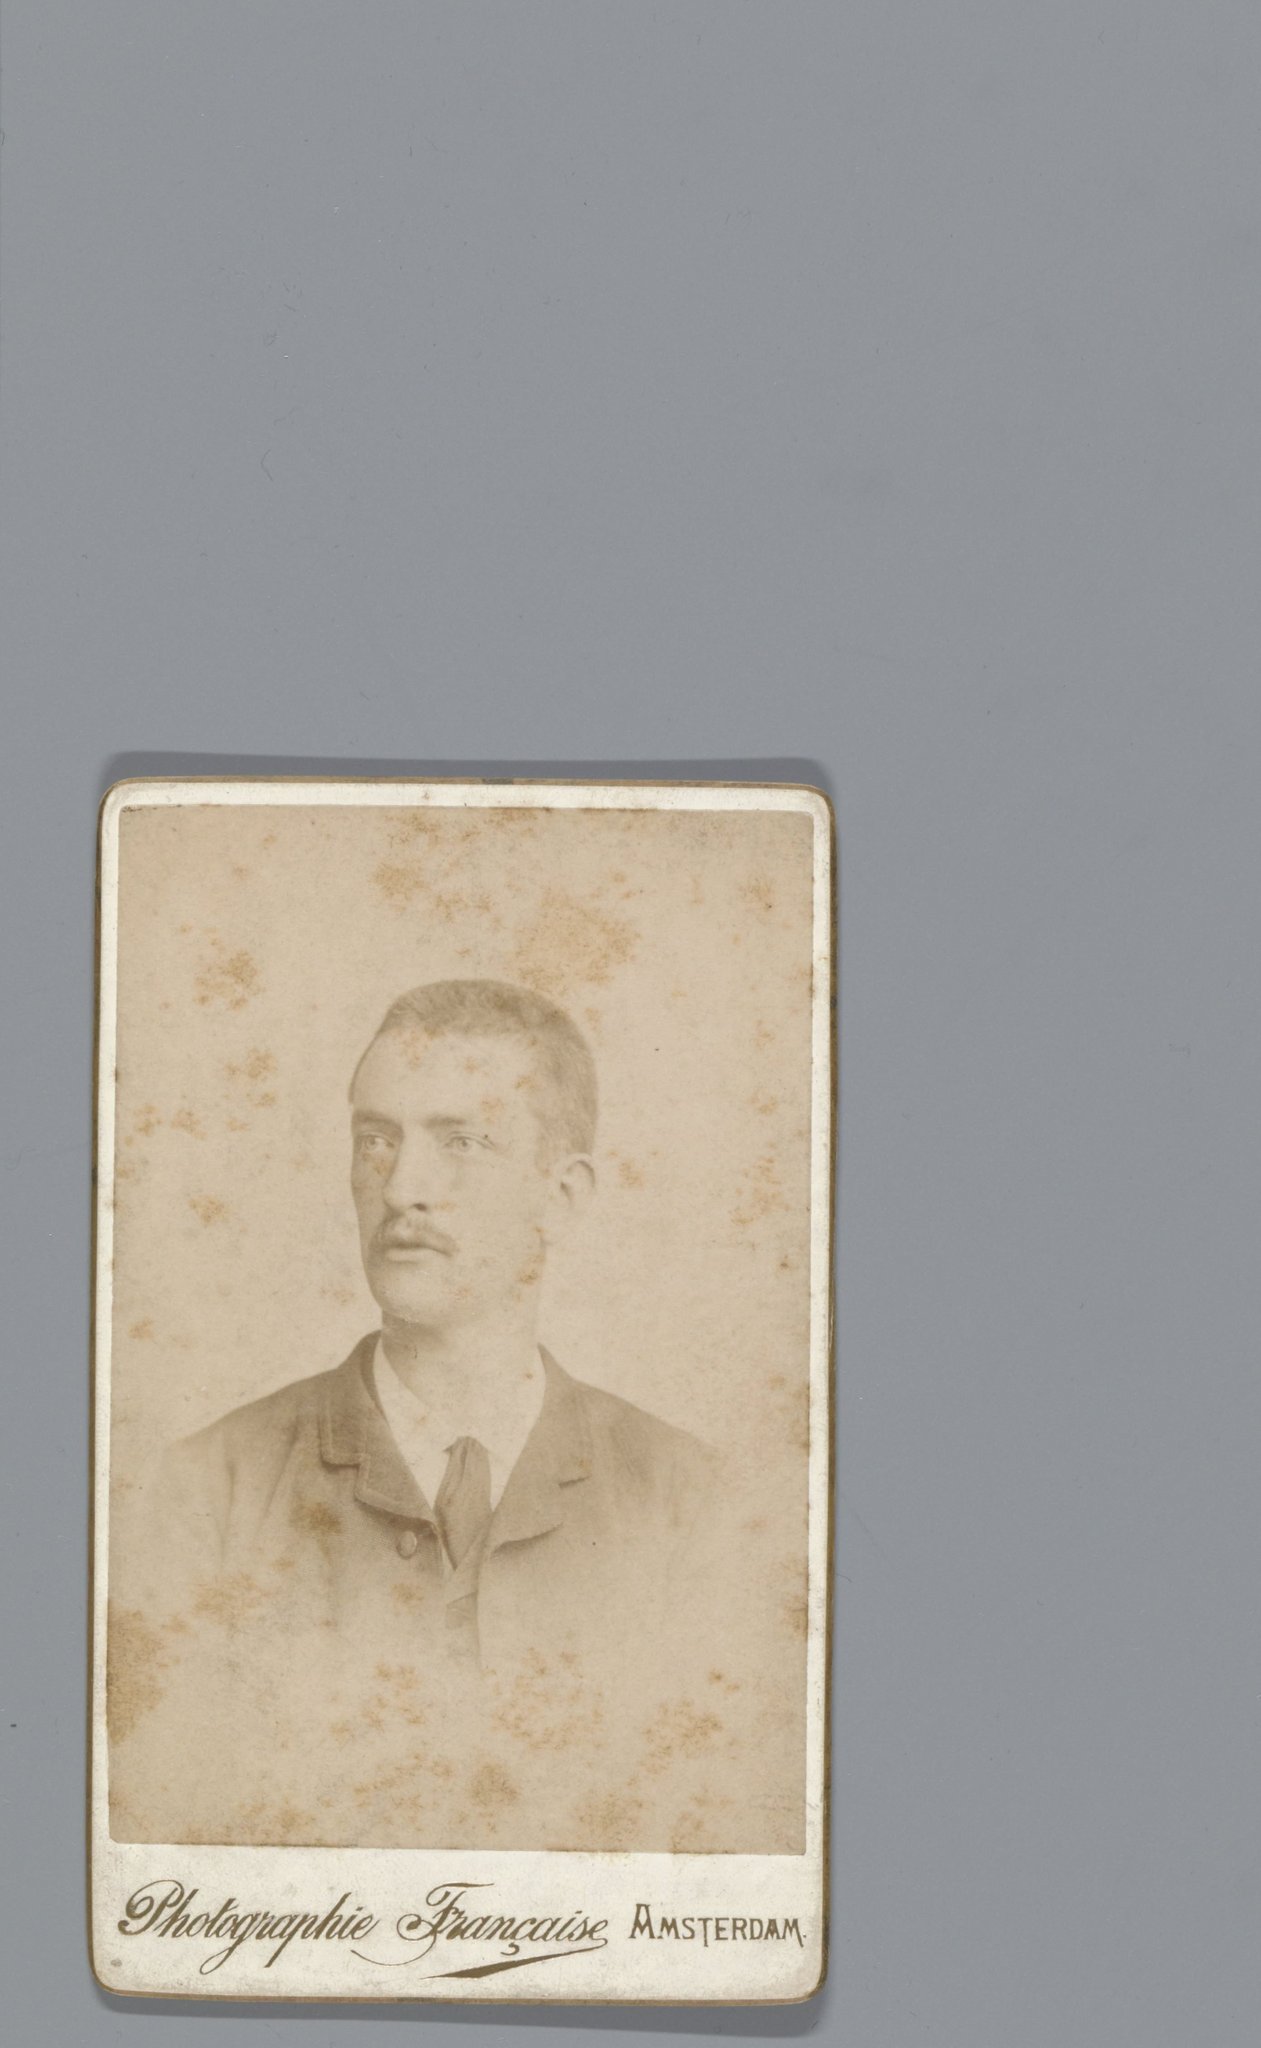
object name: photograph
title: J. Hofker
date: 1860-1915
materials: cardboard, paper, photographic support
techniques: albumen print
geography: netherlands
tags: amsterdam